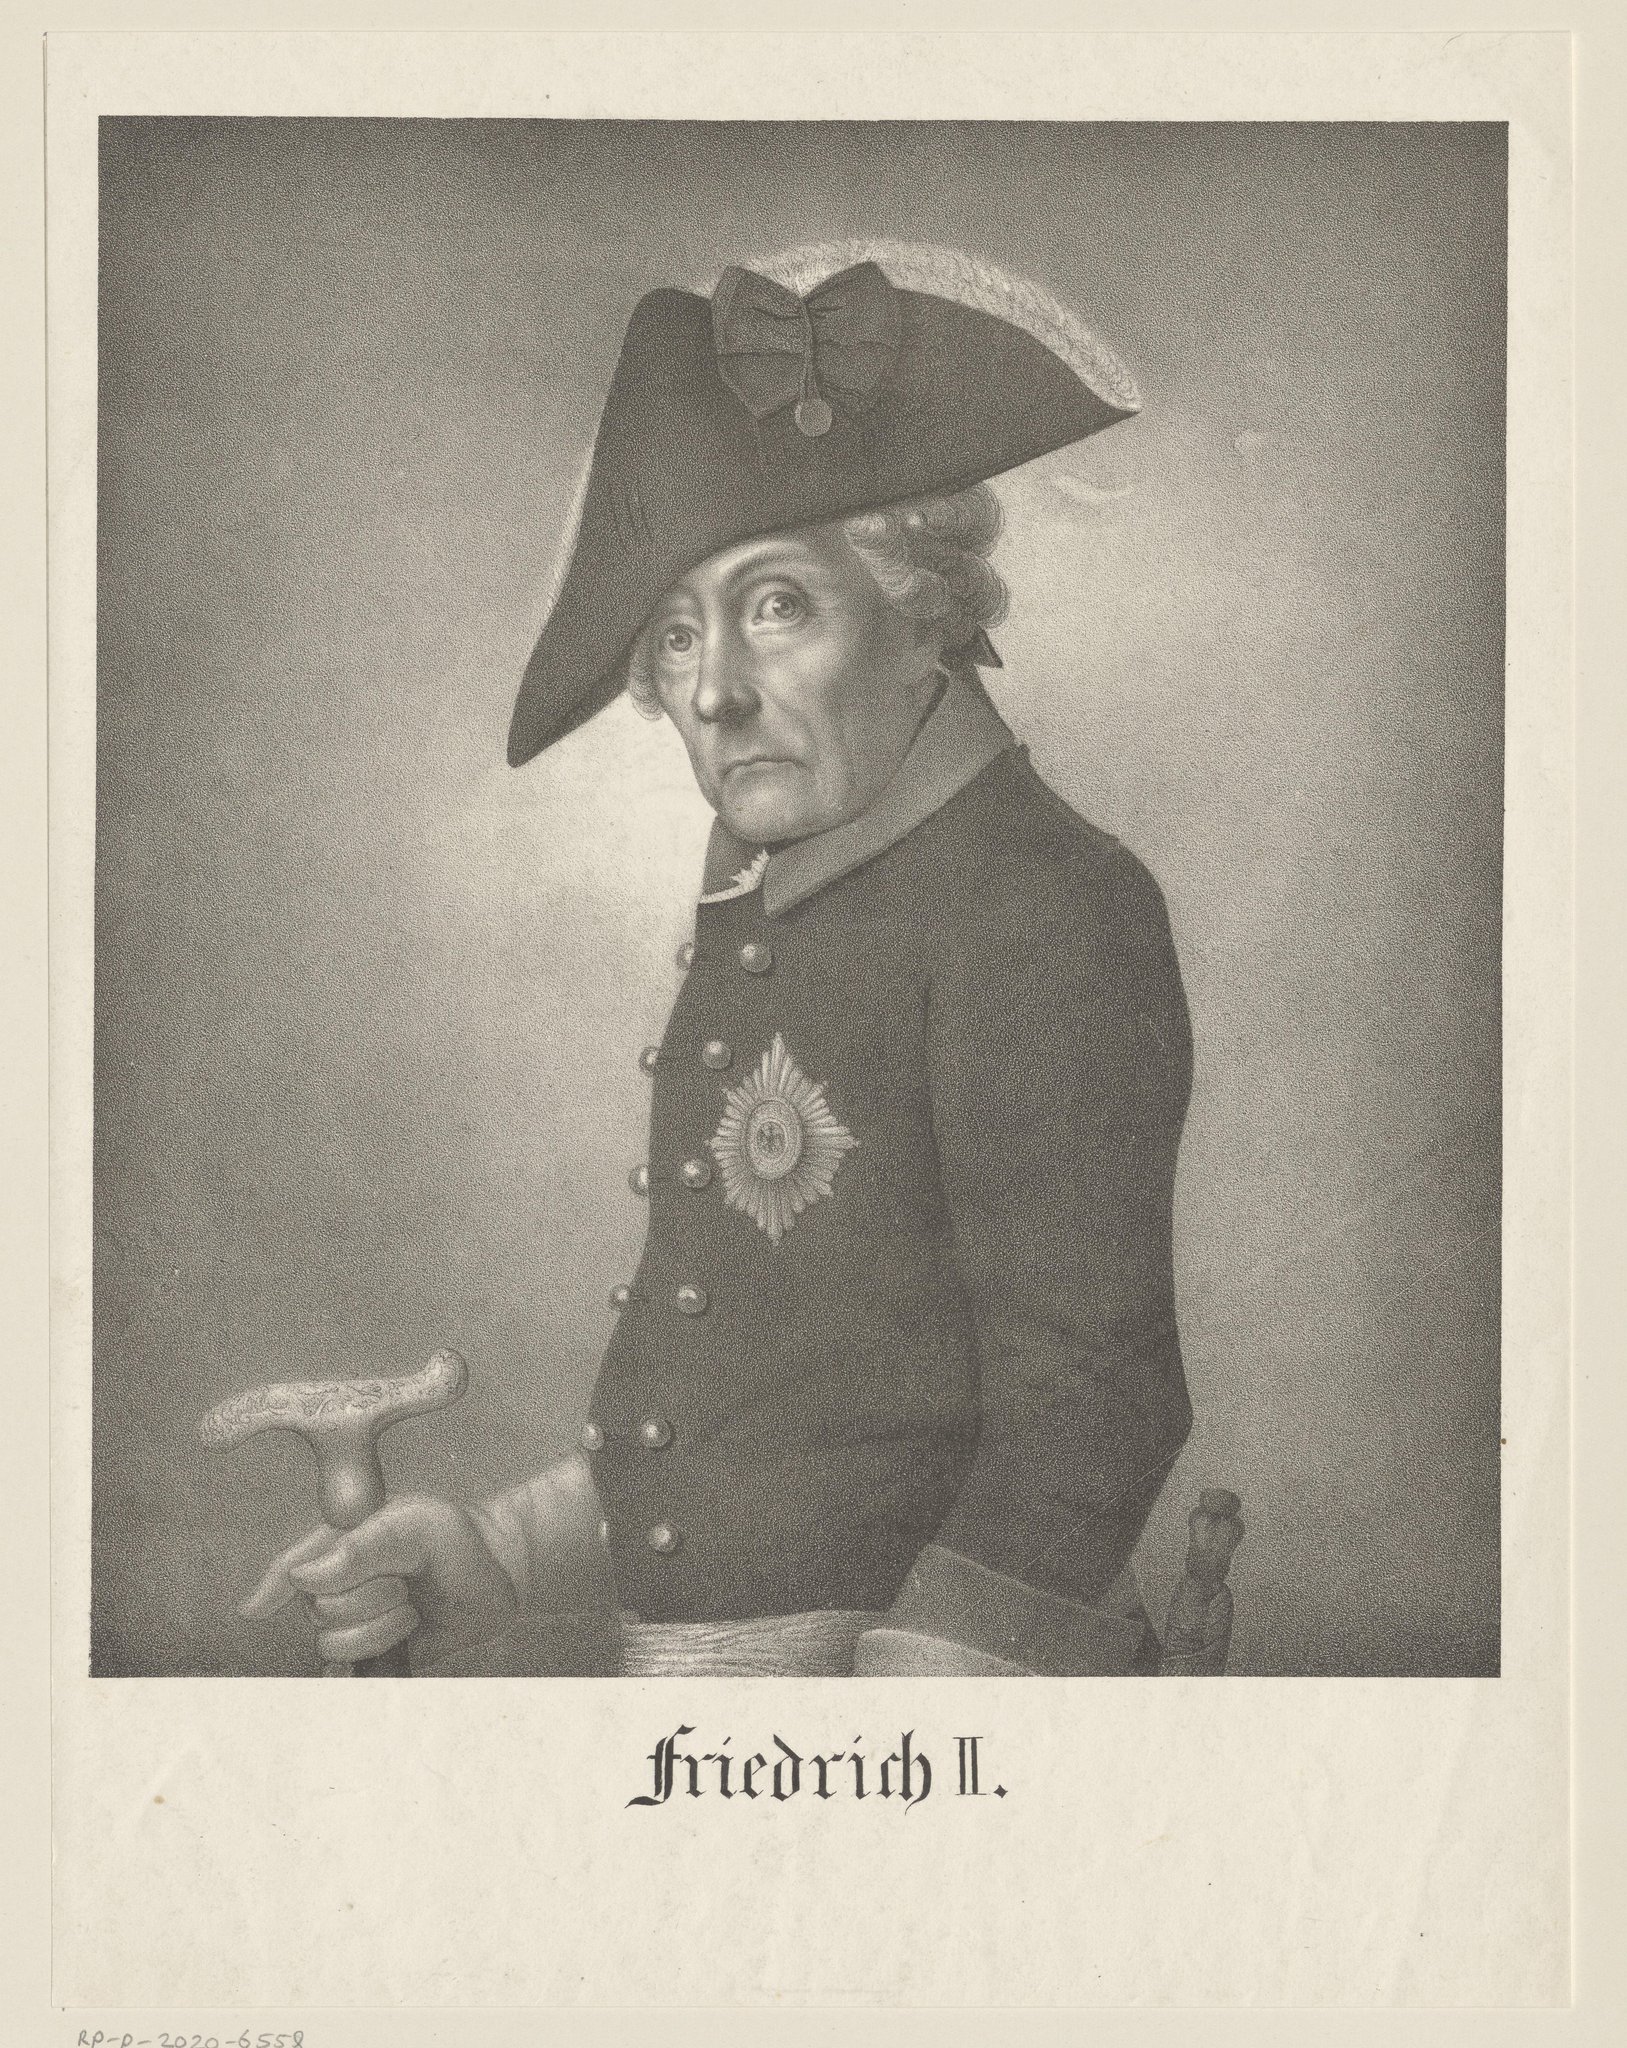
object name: print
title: Portret van Frederik de Grote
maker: Anonymous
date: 1800-1899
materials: paper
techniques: lithograph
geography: germany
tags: frederick ii (king of prussia), historical persons, king